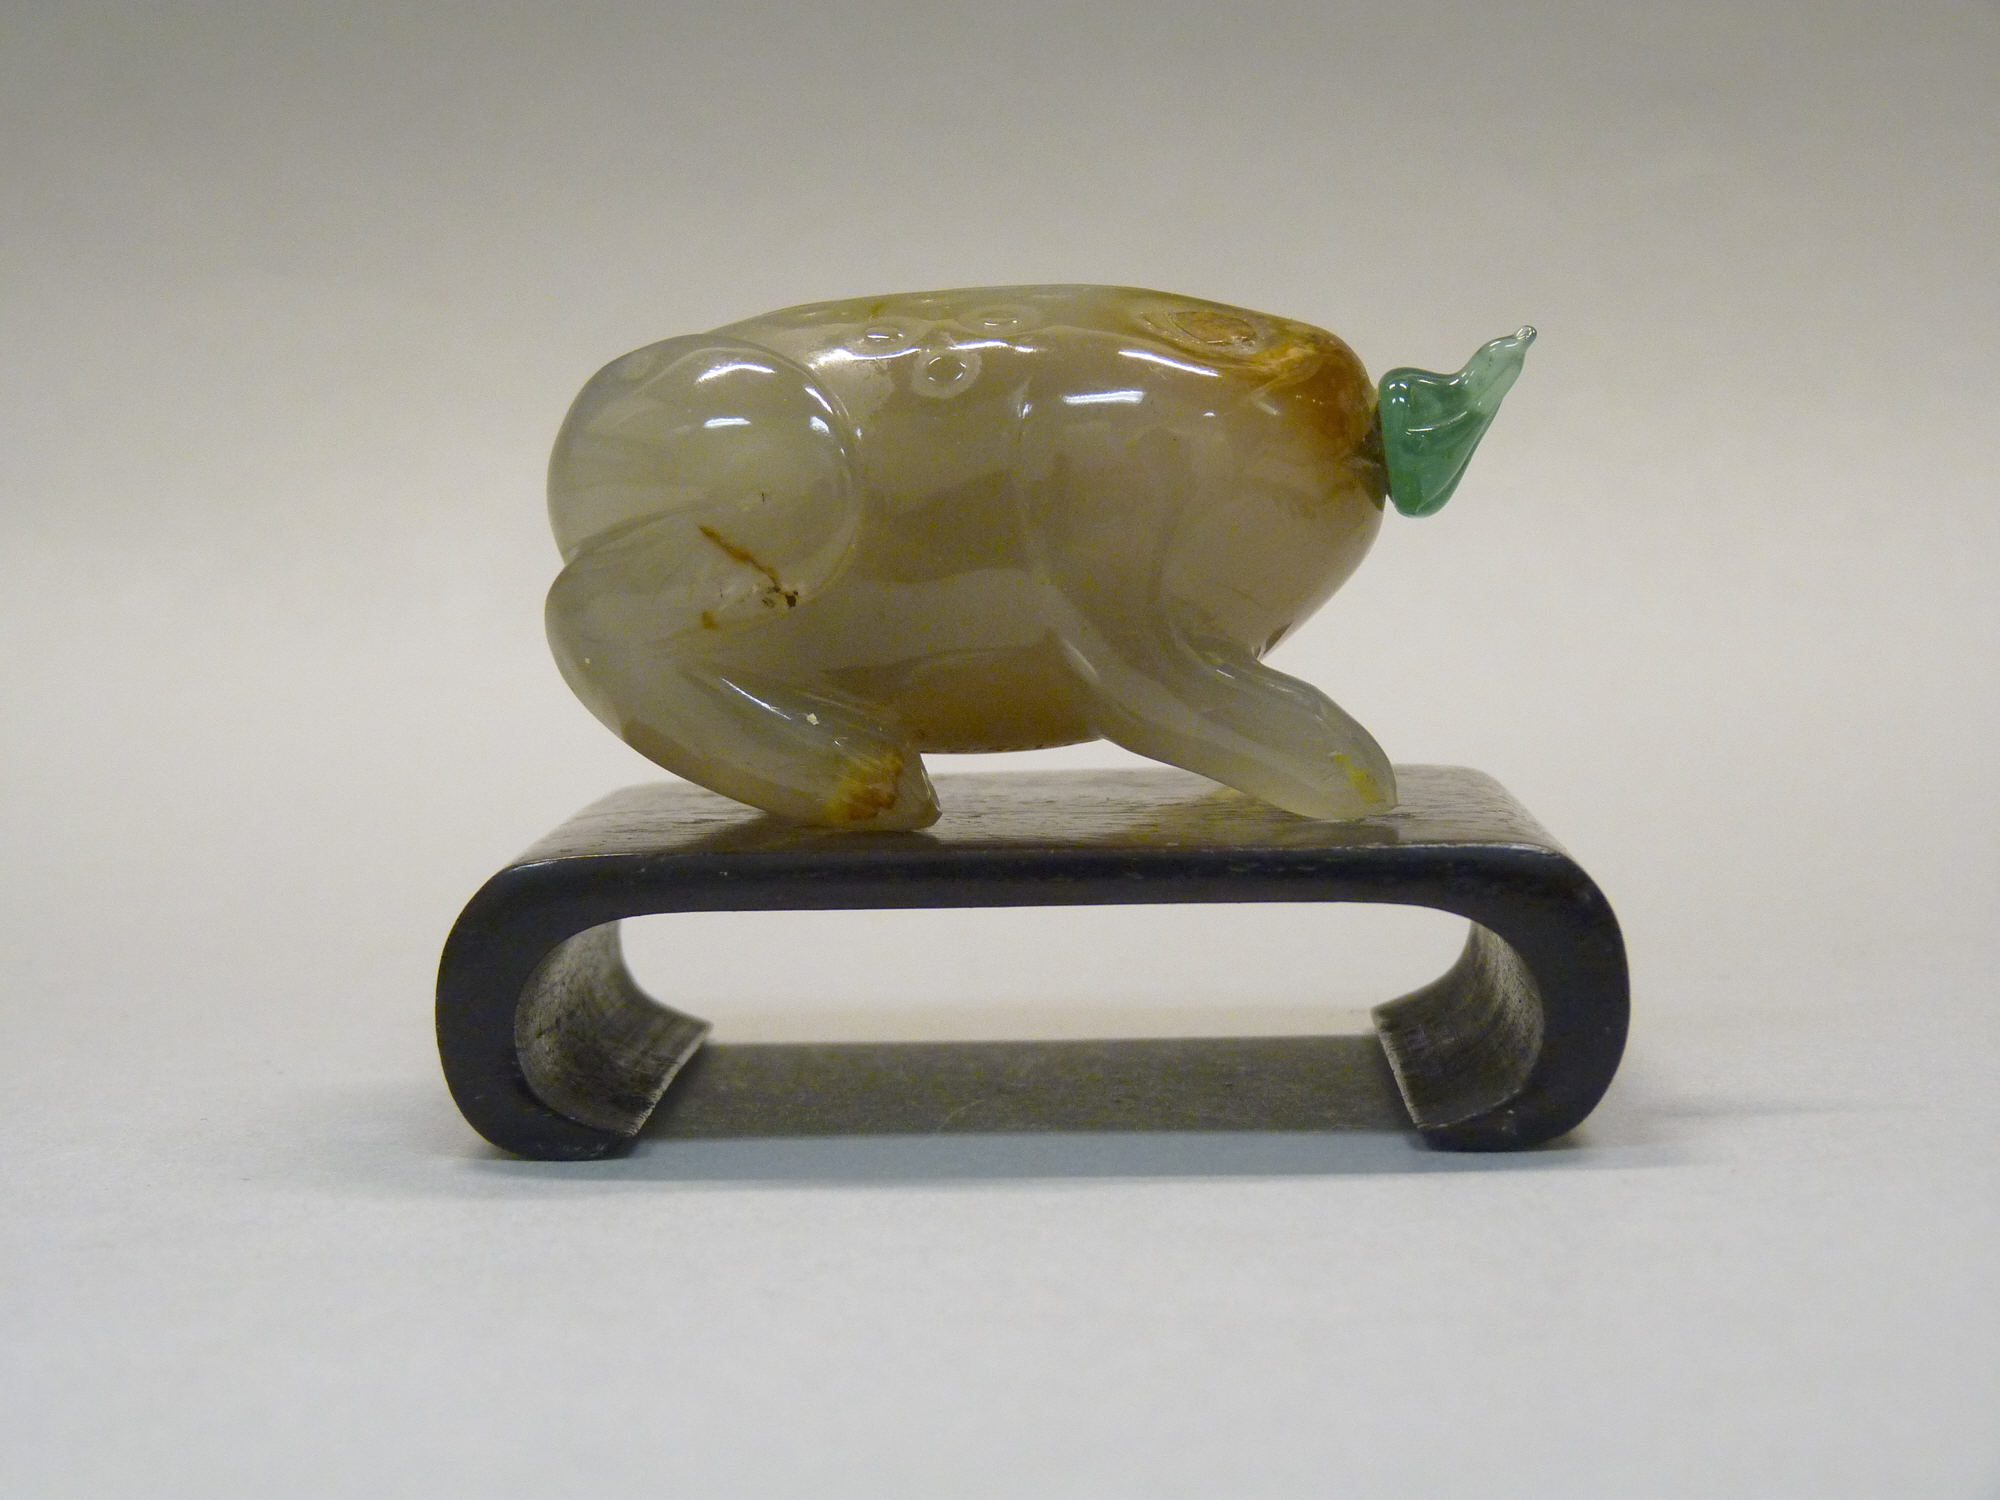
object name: snuff bottle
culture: chinese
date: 1736-1795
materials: stone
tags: frogs